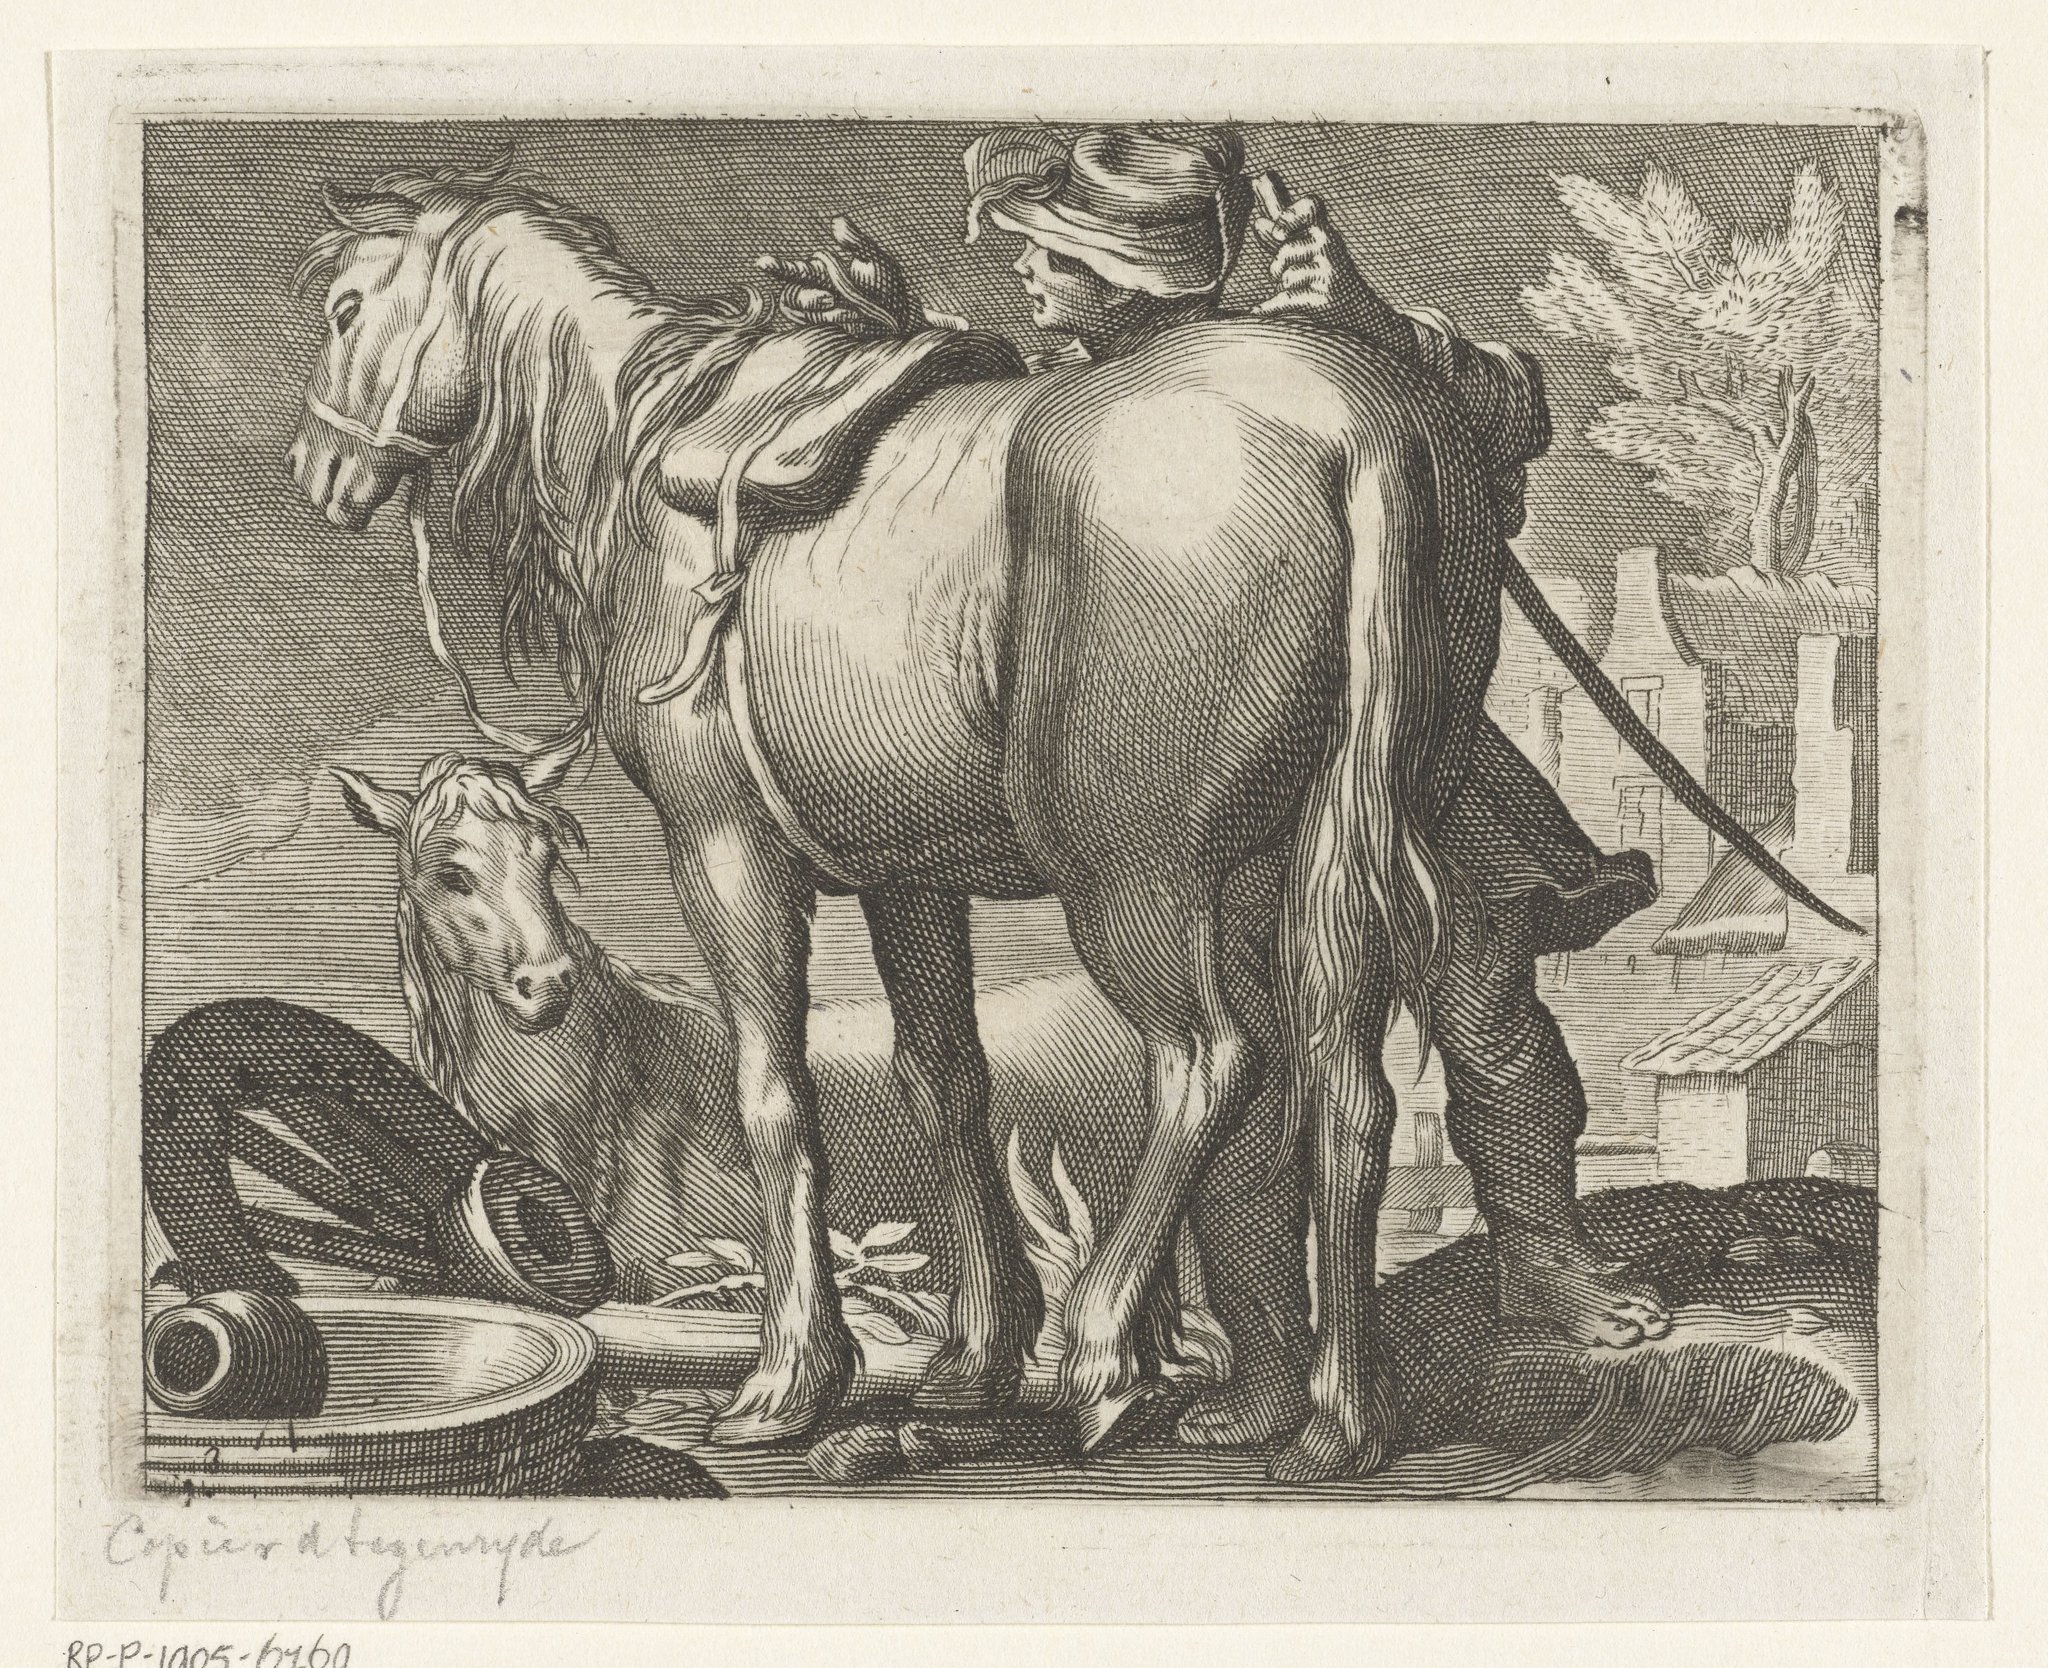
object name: print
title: Paarden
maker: Anonymous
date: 1611-1661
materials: paper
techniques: engraving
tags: horse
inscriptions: collector's mark: Lugt 2228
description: Kopie in spiegelbeeld naar prent uit serie met veertien prenten zogenaamde Pastoralen van B.A. Bolswert naar ontwerp van Abraham Bloemaert.